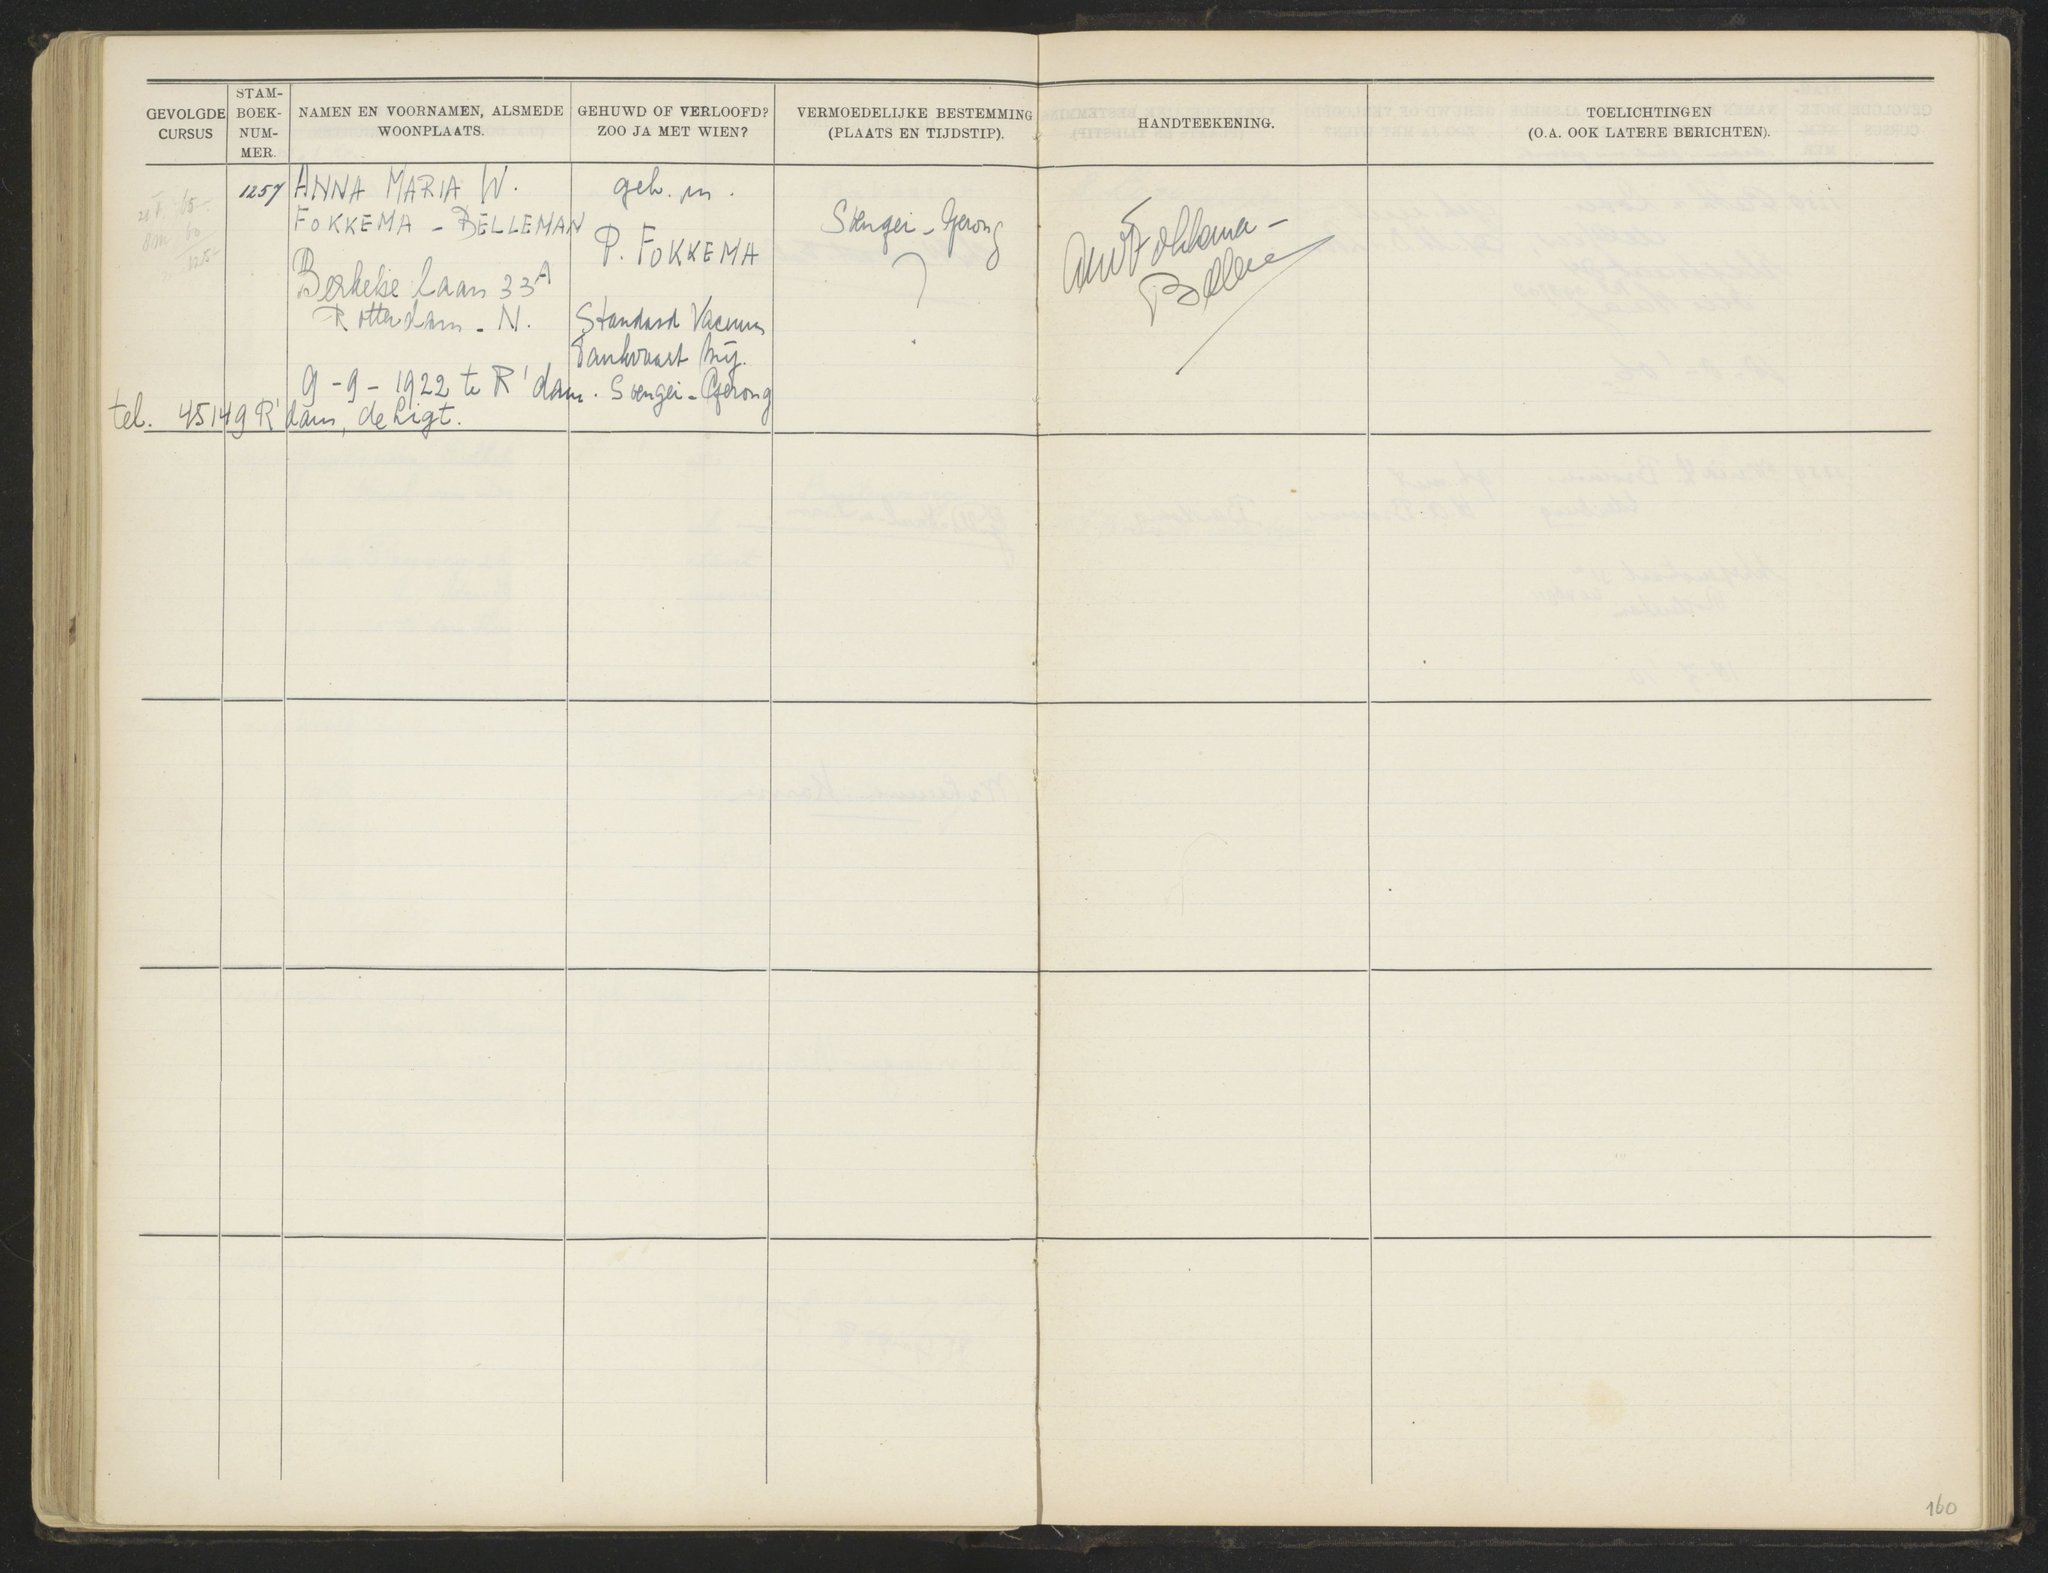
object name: album leaf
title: Blad 160 uit Stamboek van de leerlingen der Koloniale School voor Meisjes en Vrouwen te 's-Gravenhage deel II (1930-1949)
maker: Anonymous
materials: paper, photographic support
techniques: photography, printing, writing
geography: the hague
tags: further education (+ pupil), further education, the hague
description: Twee pagina's met gegevens van een deelnemer aan een cursus, stamboeknummer 1257. Doordat de datumaanduiding in de eerste kolom ontbreekt is niet duidelijk om welke cursus het gaat. Gelet op de doorlopende stamboeknummers betreft het naar alle waarschijnlijkheid een cursist van het laatste schooljaar 1949. De Koloniale School sloot op 29 december 1949, na de soevereiniteitsoverdracht aan Indonesië, voorgoed haar poorten. Onderdeel van Stamboek van de leerlingen der Koloniale School voor Meisjes en Vrouwen te 's-Gravenhage deel II (1930-1949).